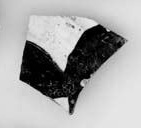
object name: shard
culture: korean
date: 1401-1500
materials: pottery